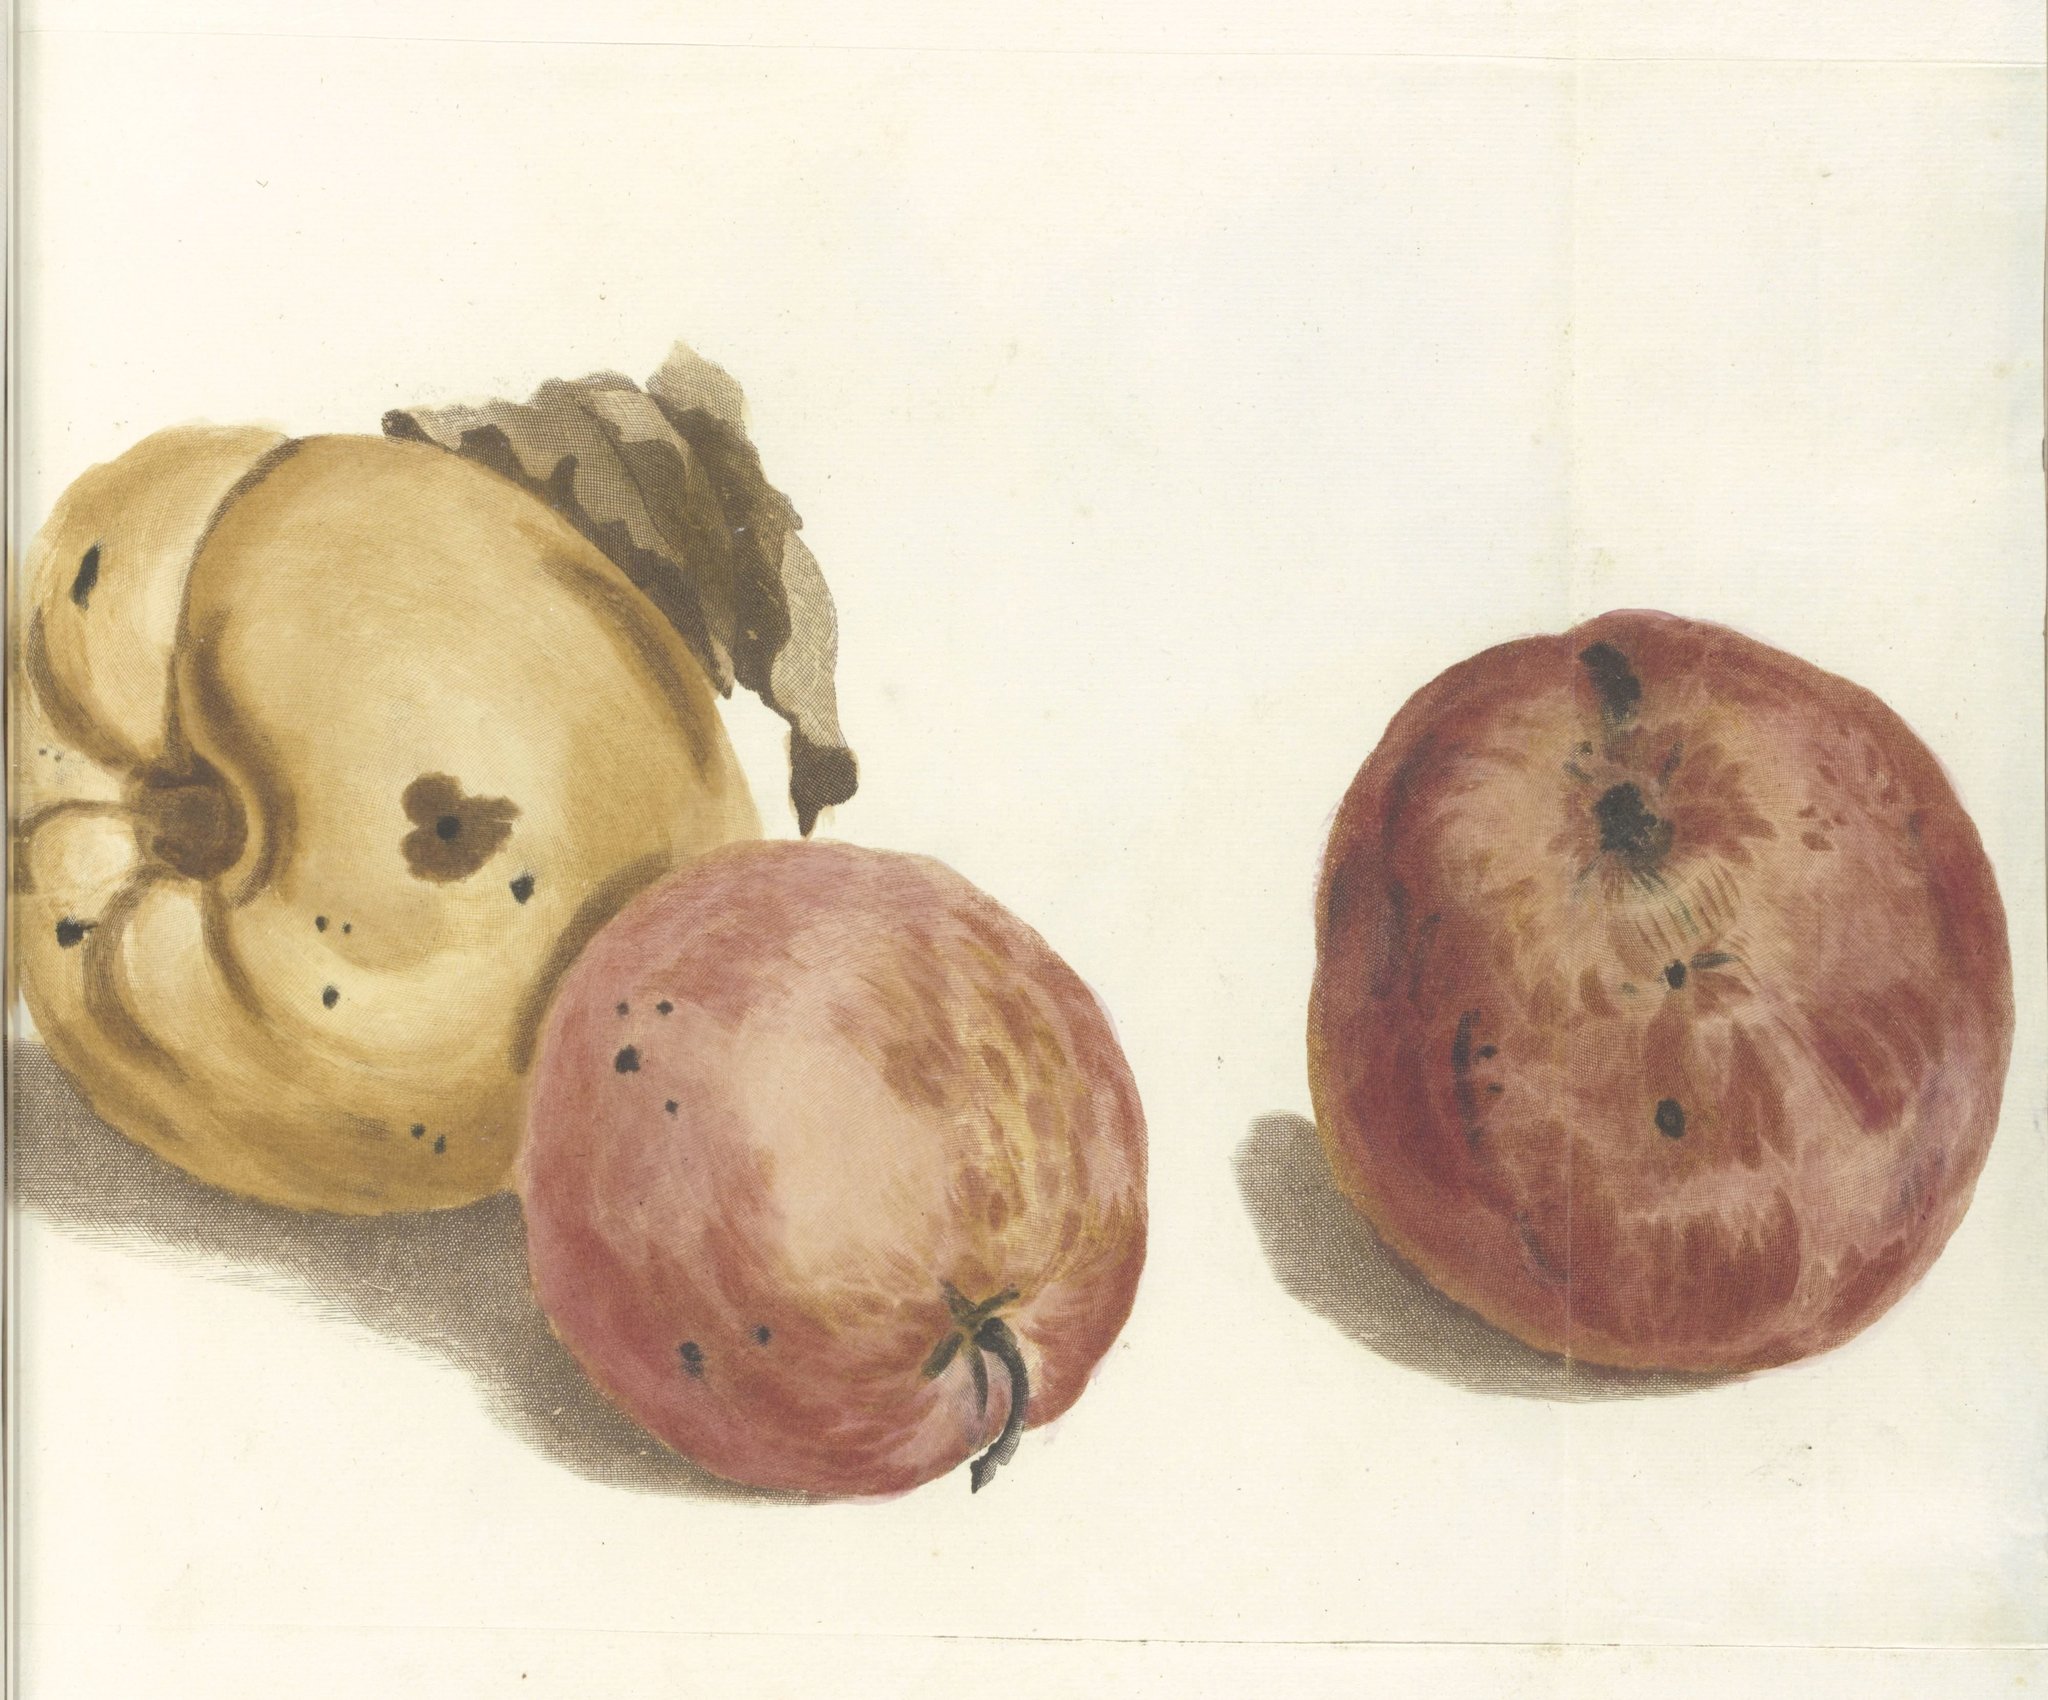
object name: album leaf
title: Kweepeer en twee appels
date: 1688-1698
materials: paper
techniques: printing, engraving, hand coloring, lithography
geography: netherlands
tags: fruits: apple, fruits: quince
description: Deze prent maakt deel uit van een album.